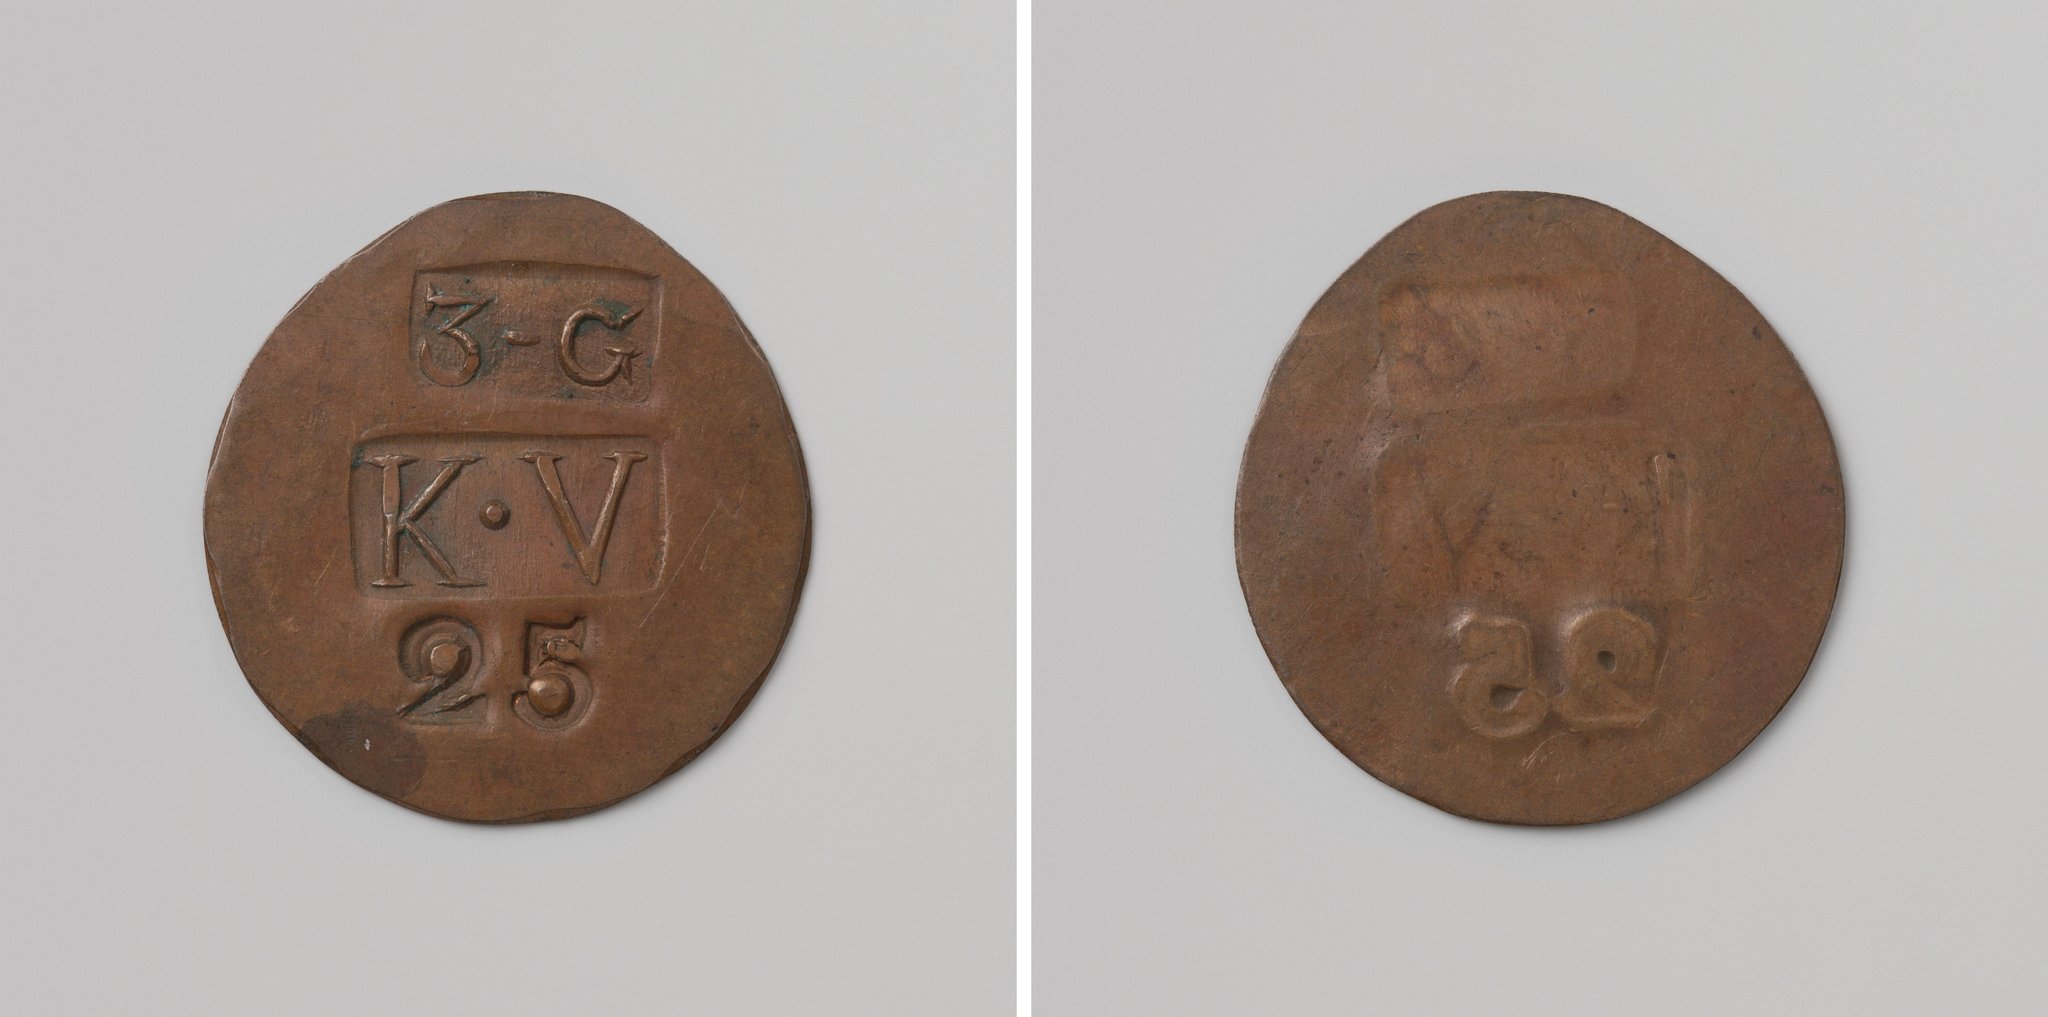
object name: monetary token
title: Derde gesticht van de kolonie Veenhuizen, huismunt geslagen op last van de Maatschappij van Weldadigheid ter waarde van 25 cent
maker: Anonymous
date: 1818-1859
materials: copper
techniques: striking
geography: netherlands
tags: maatschappij van weldadigheid, veenhuizen